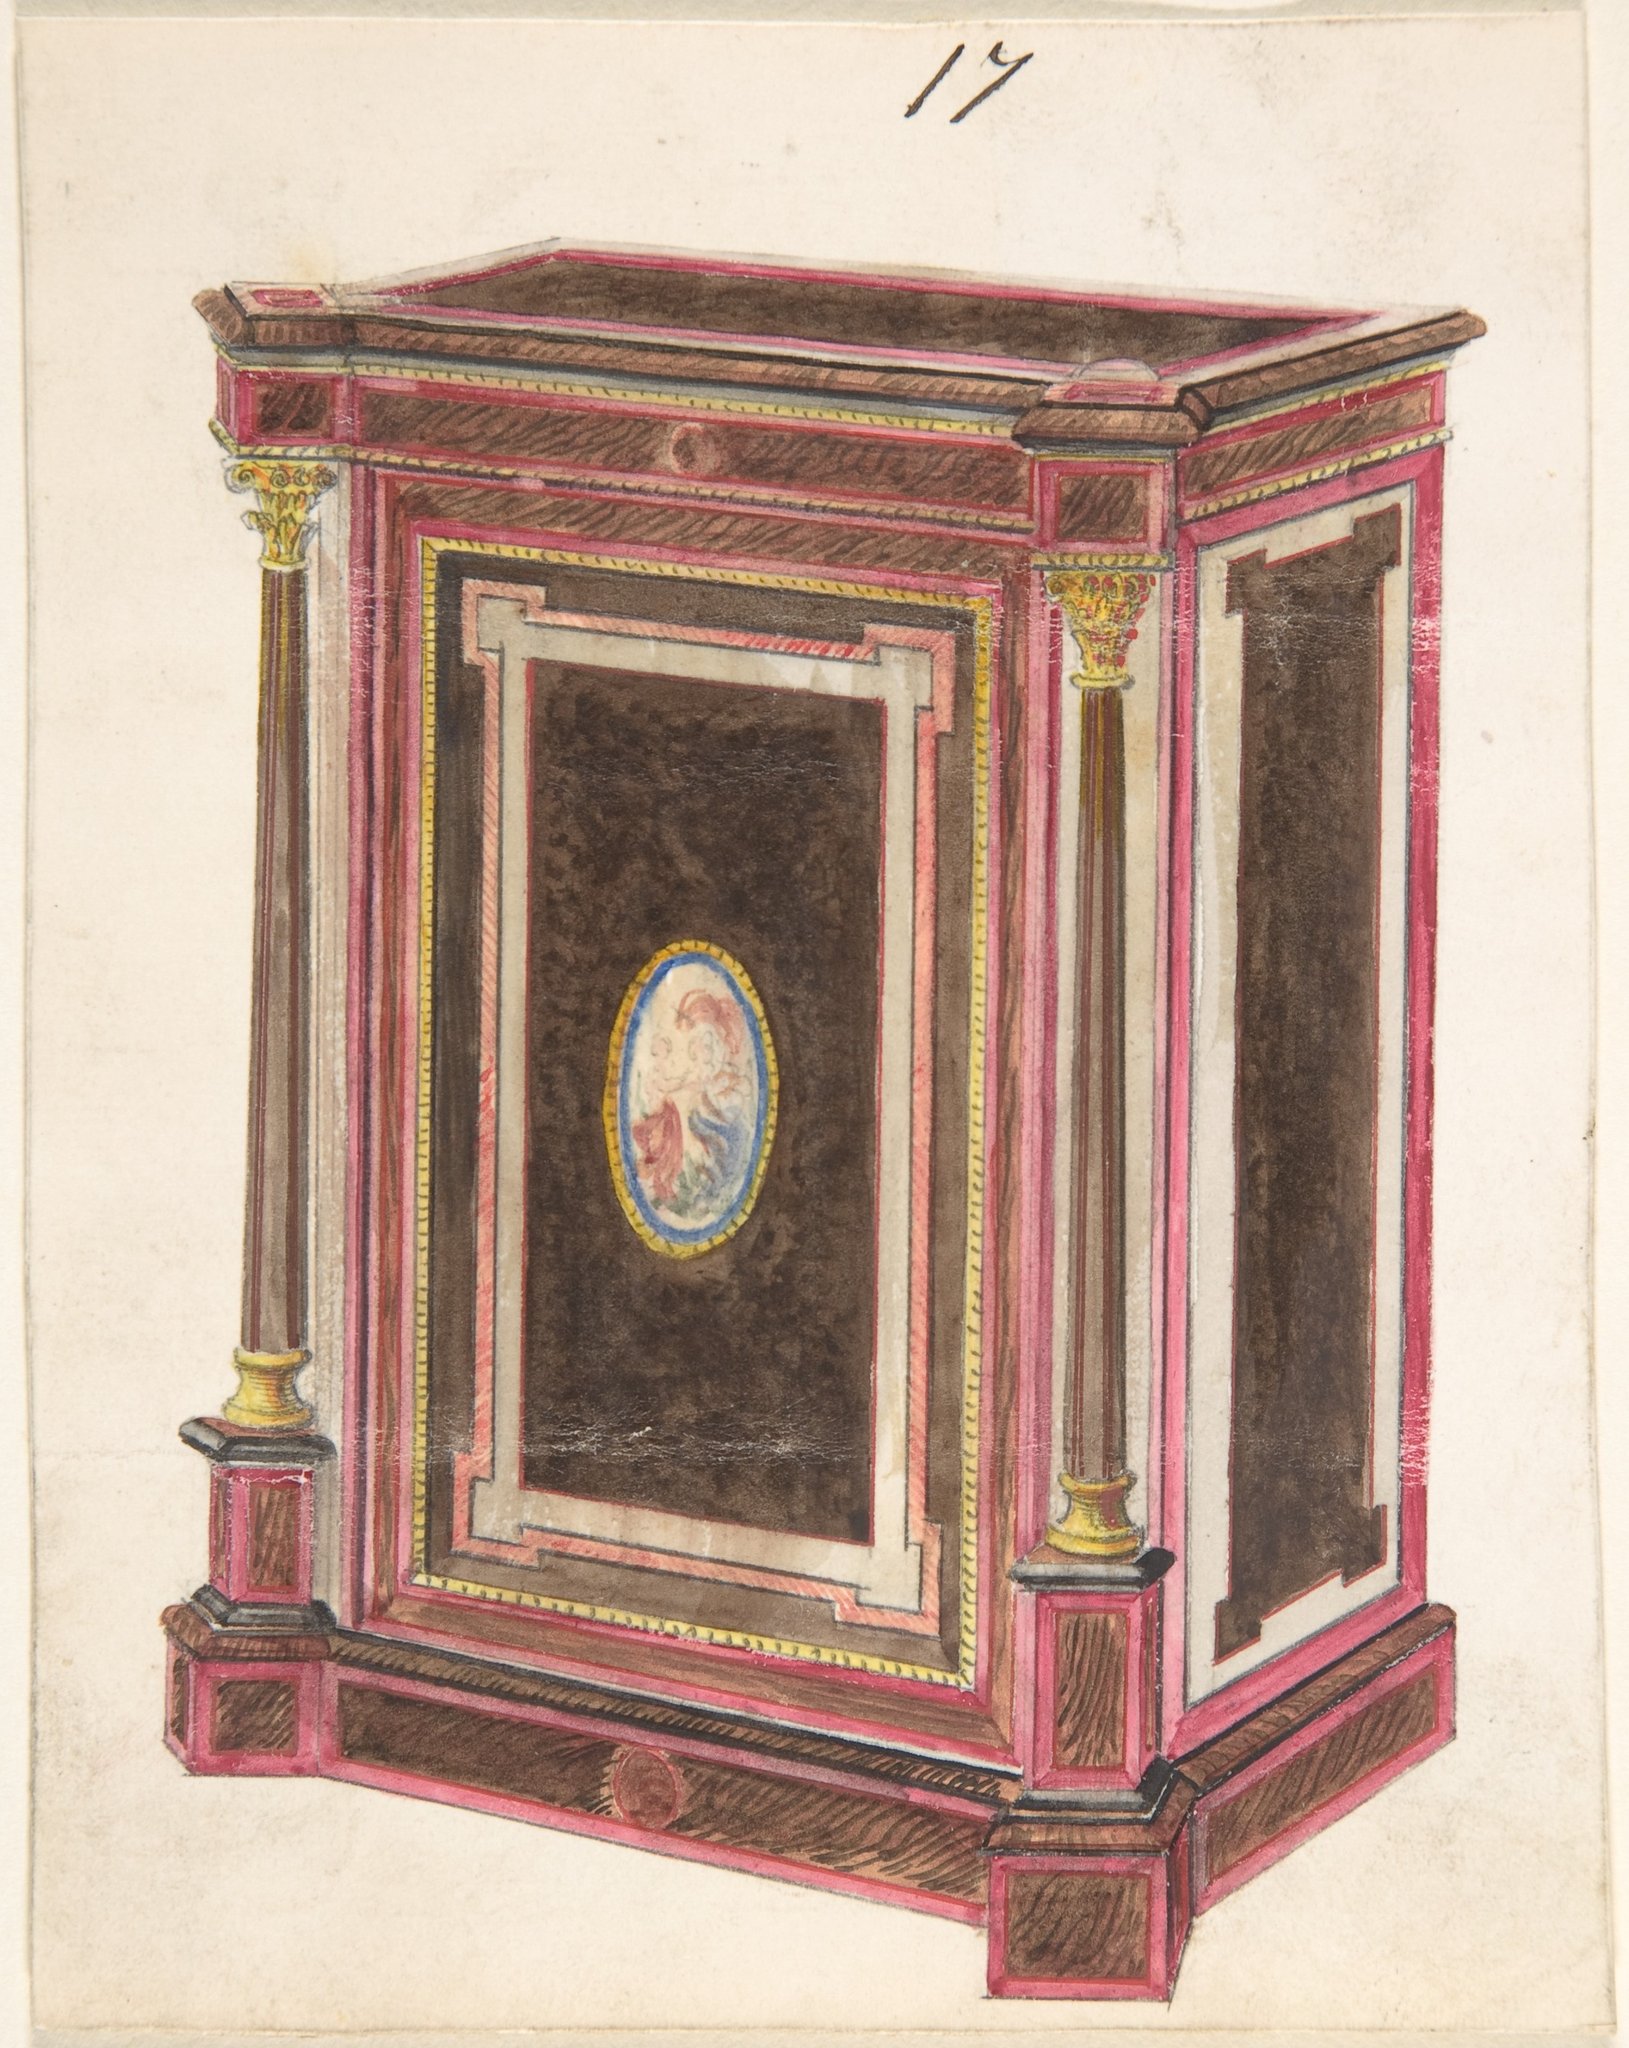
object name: drawing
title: Cabinet Design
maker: anonymous, british, 19th century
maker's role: artist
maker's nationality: british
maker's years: 1800-1900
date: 1801-1900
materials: ink, watercolor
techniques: pen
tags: cabinets